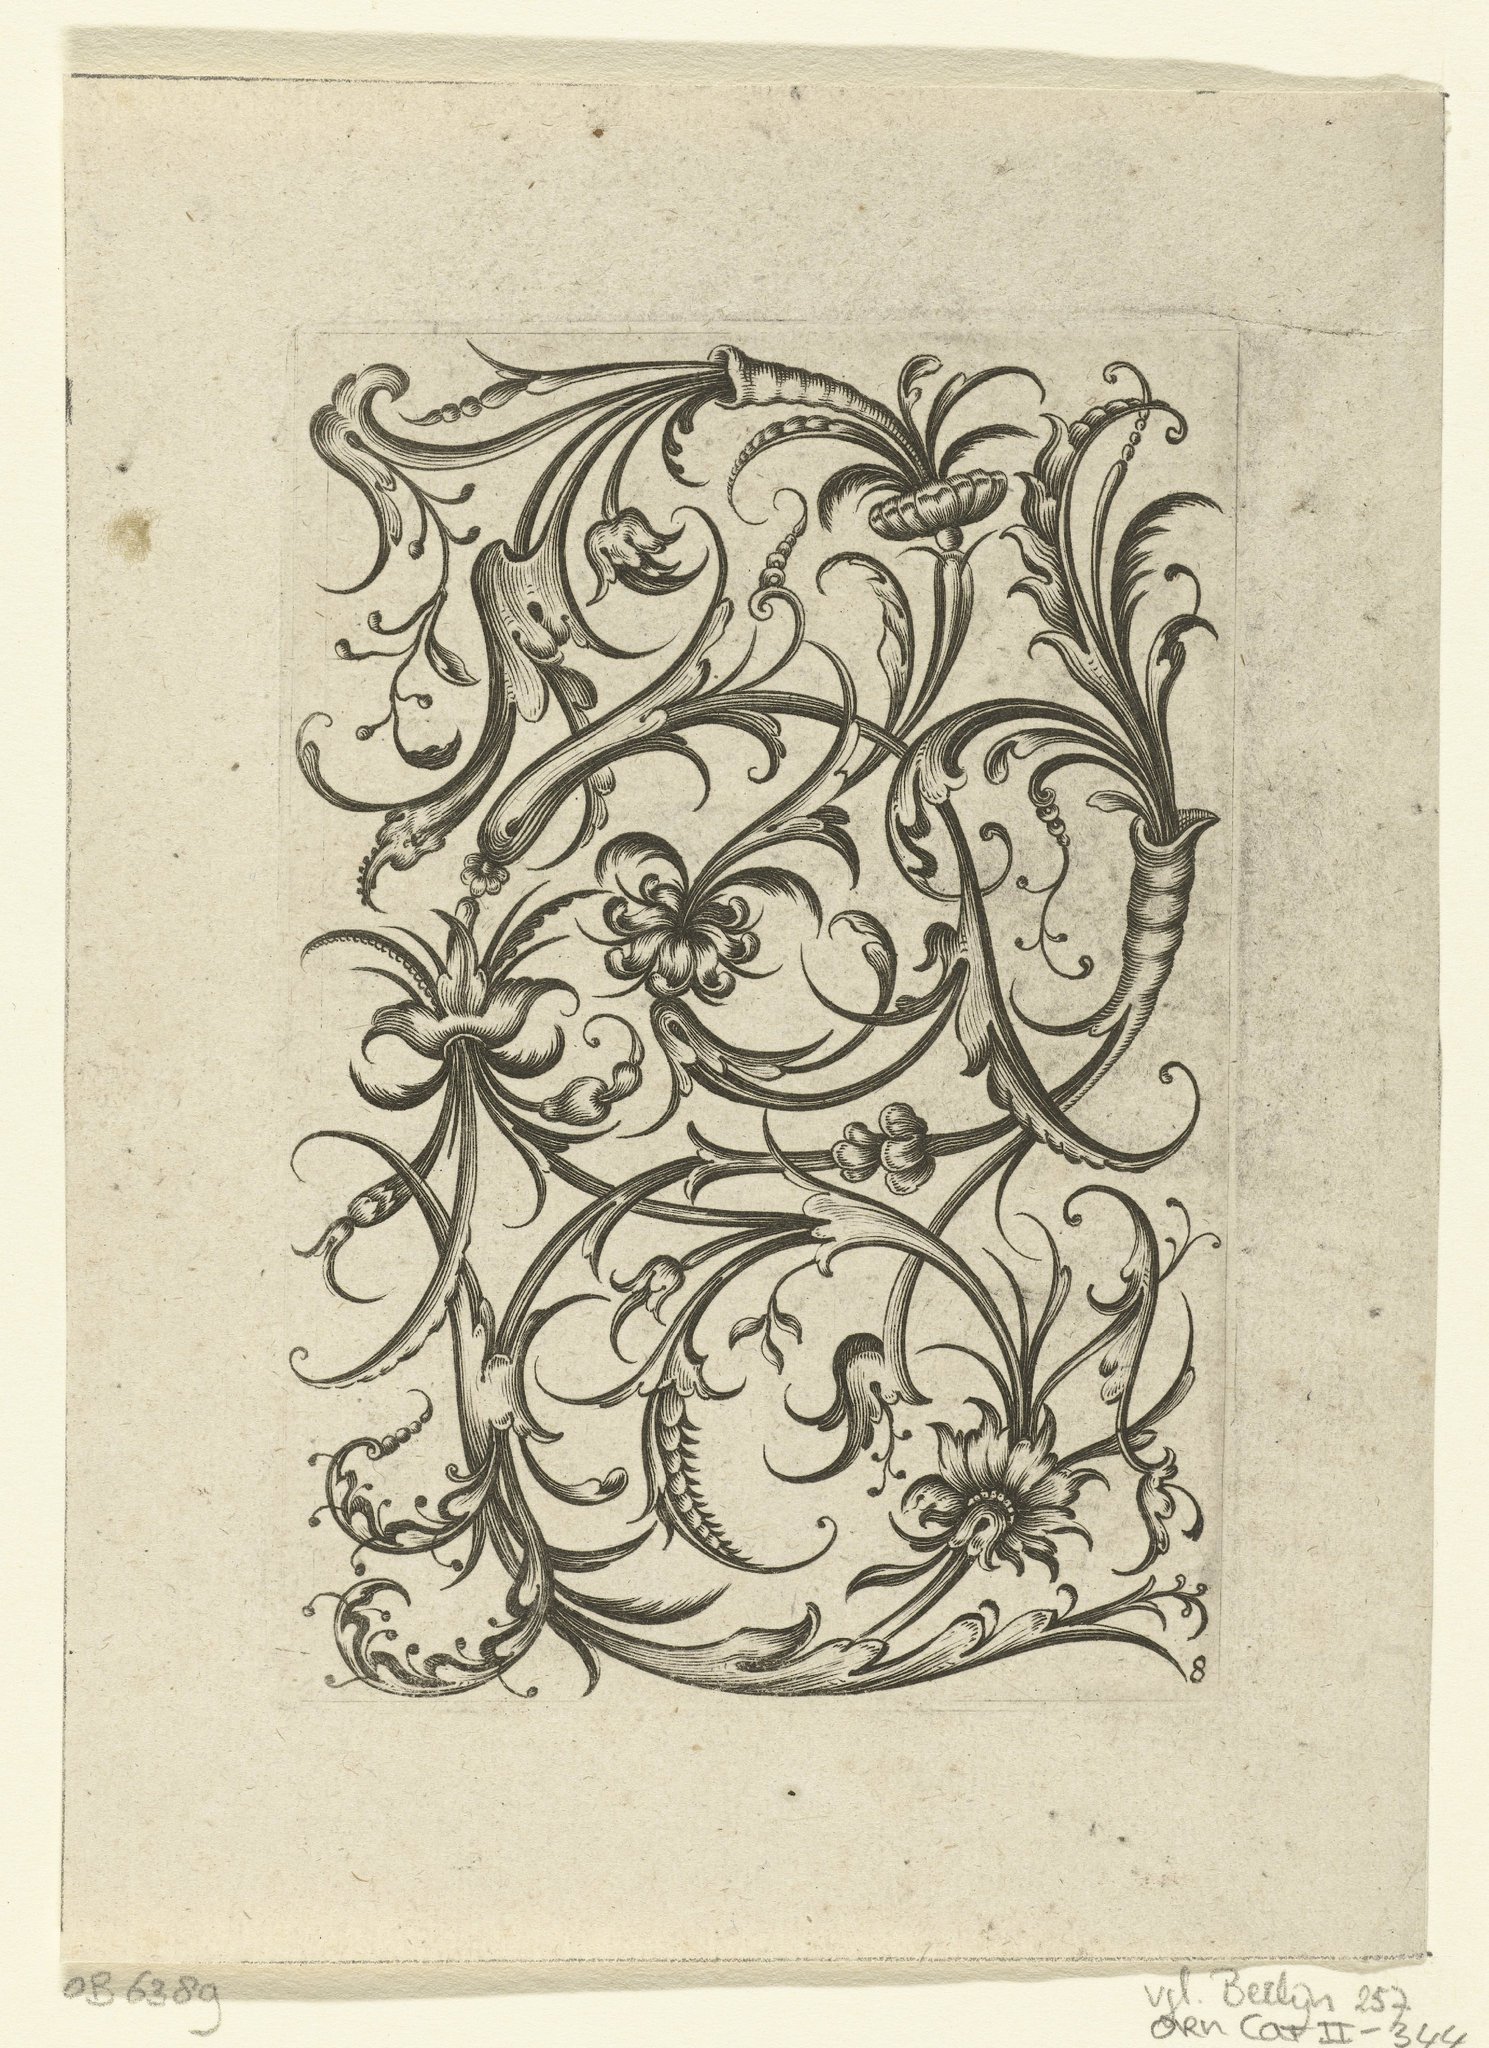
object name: ornament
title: Paneel met bladranken en bloemen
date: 1684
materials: paper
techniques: engraving, etching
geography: amsterdam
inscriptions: date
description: Blad uit serie met tegenzijdige kopieën naar de serie De Grotesco van Nicasius Rousseel.